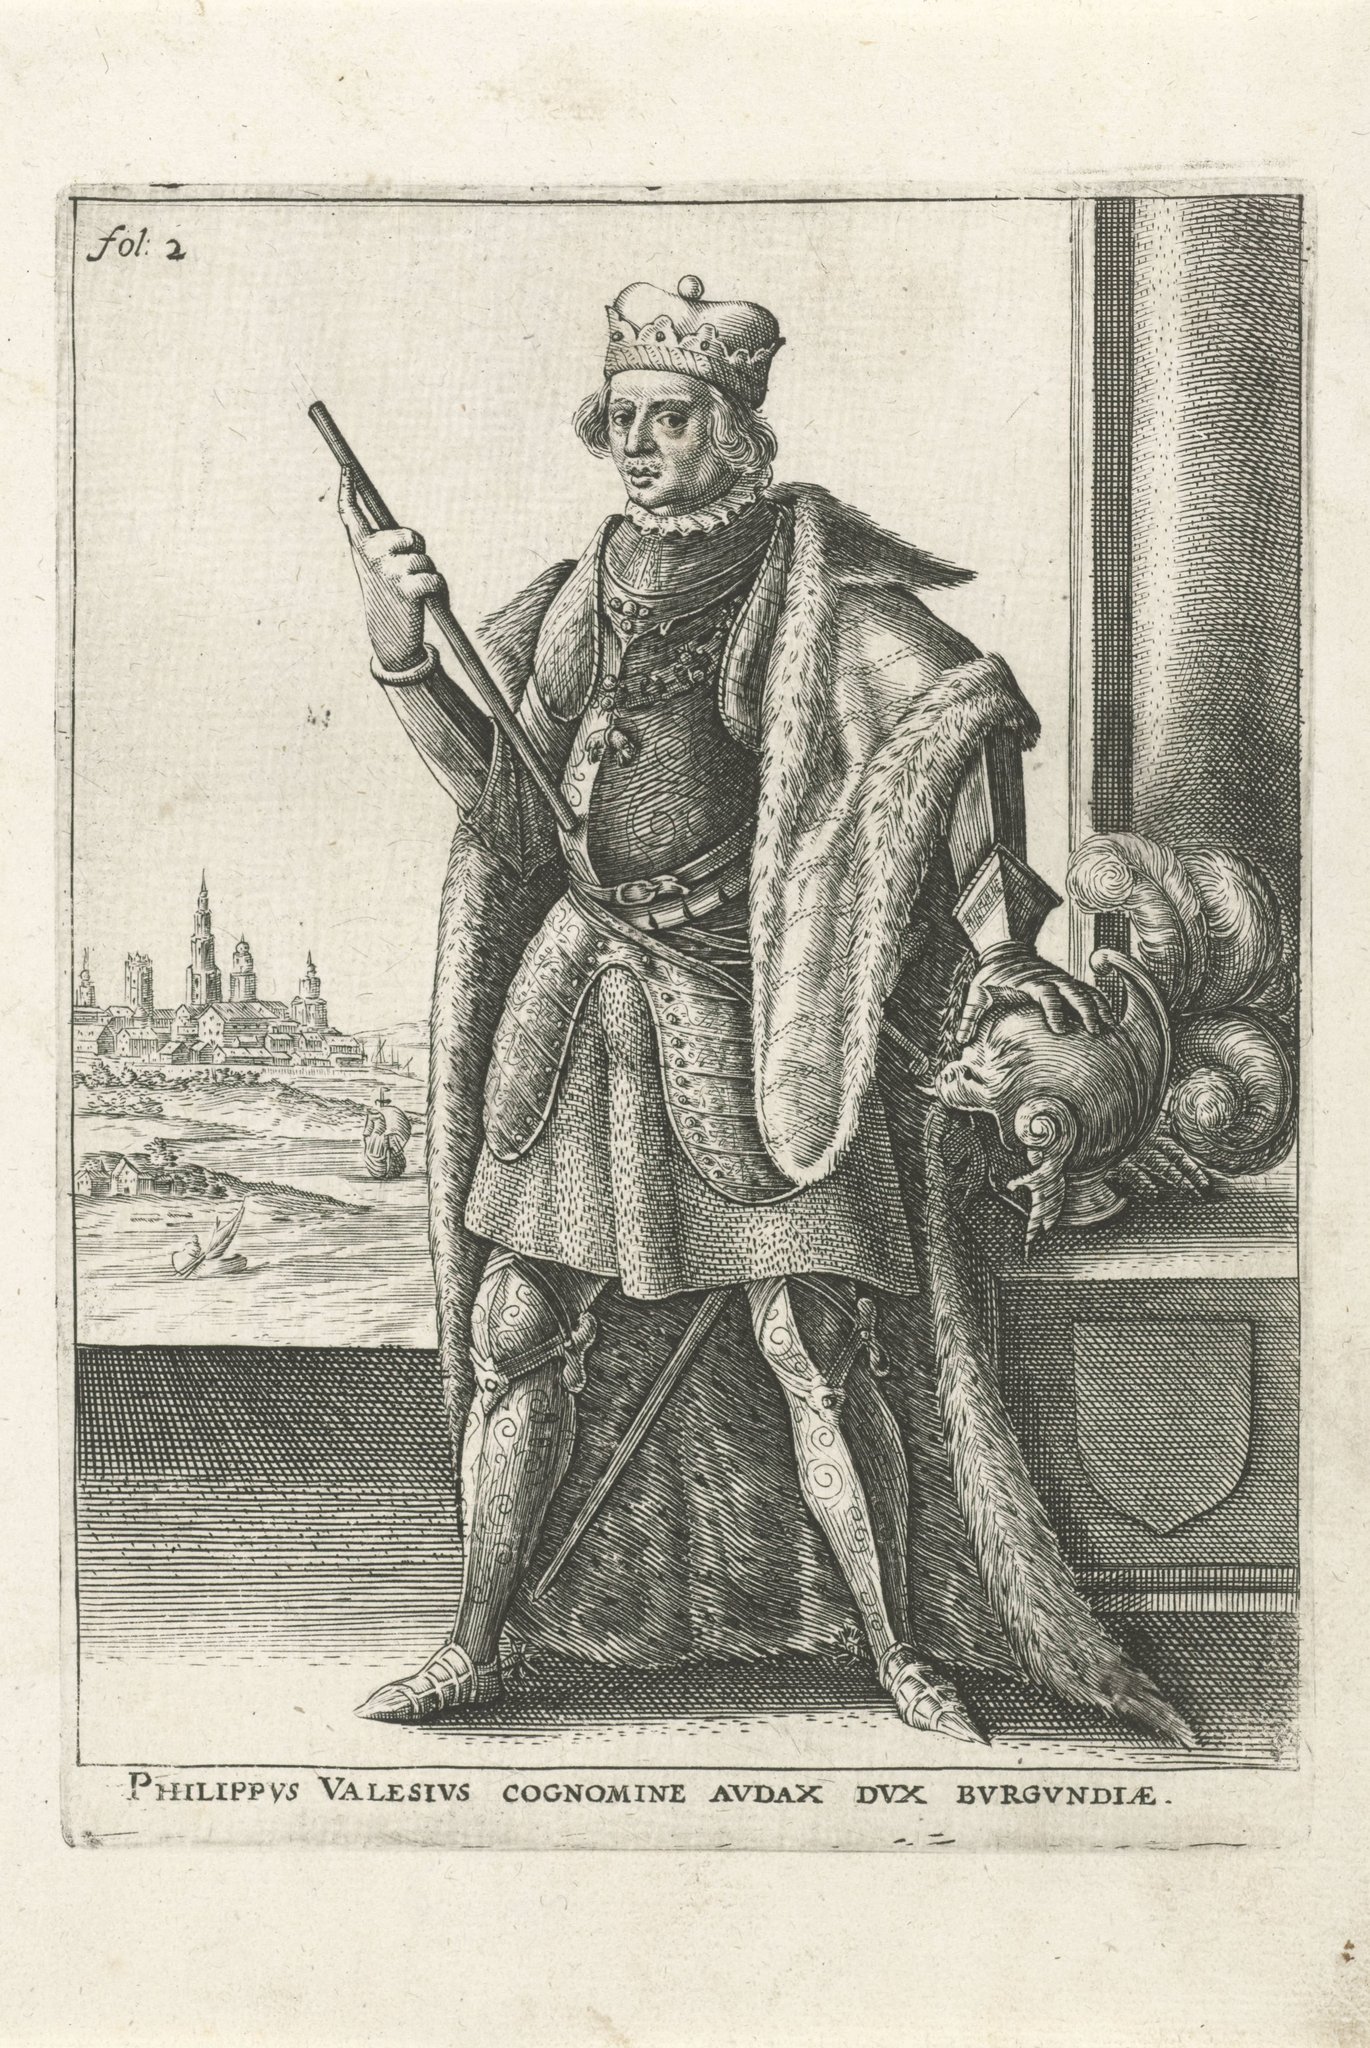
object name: book illustration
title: Hertogen van Bourgondië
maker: simon van de passe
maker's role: print maker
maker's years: 1595-1647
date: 1605-1647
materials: paper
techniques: engraving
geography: northern netherlands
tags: knighthood order of the golden fleece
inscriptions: collector's mark: Lugt 2228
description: Prent ook gebruikt in: Emanuel van Meteren, Historien der Nederlanden, en haar naburen oorlogen tot het jaar 1612 : met heerelijker konterfeijtsels dan ooyt voor dezen verciert en verbetert. Amsterdam: Jan Jacobsz Schipper, 1663.